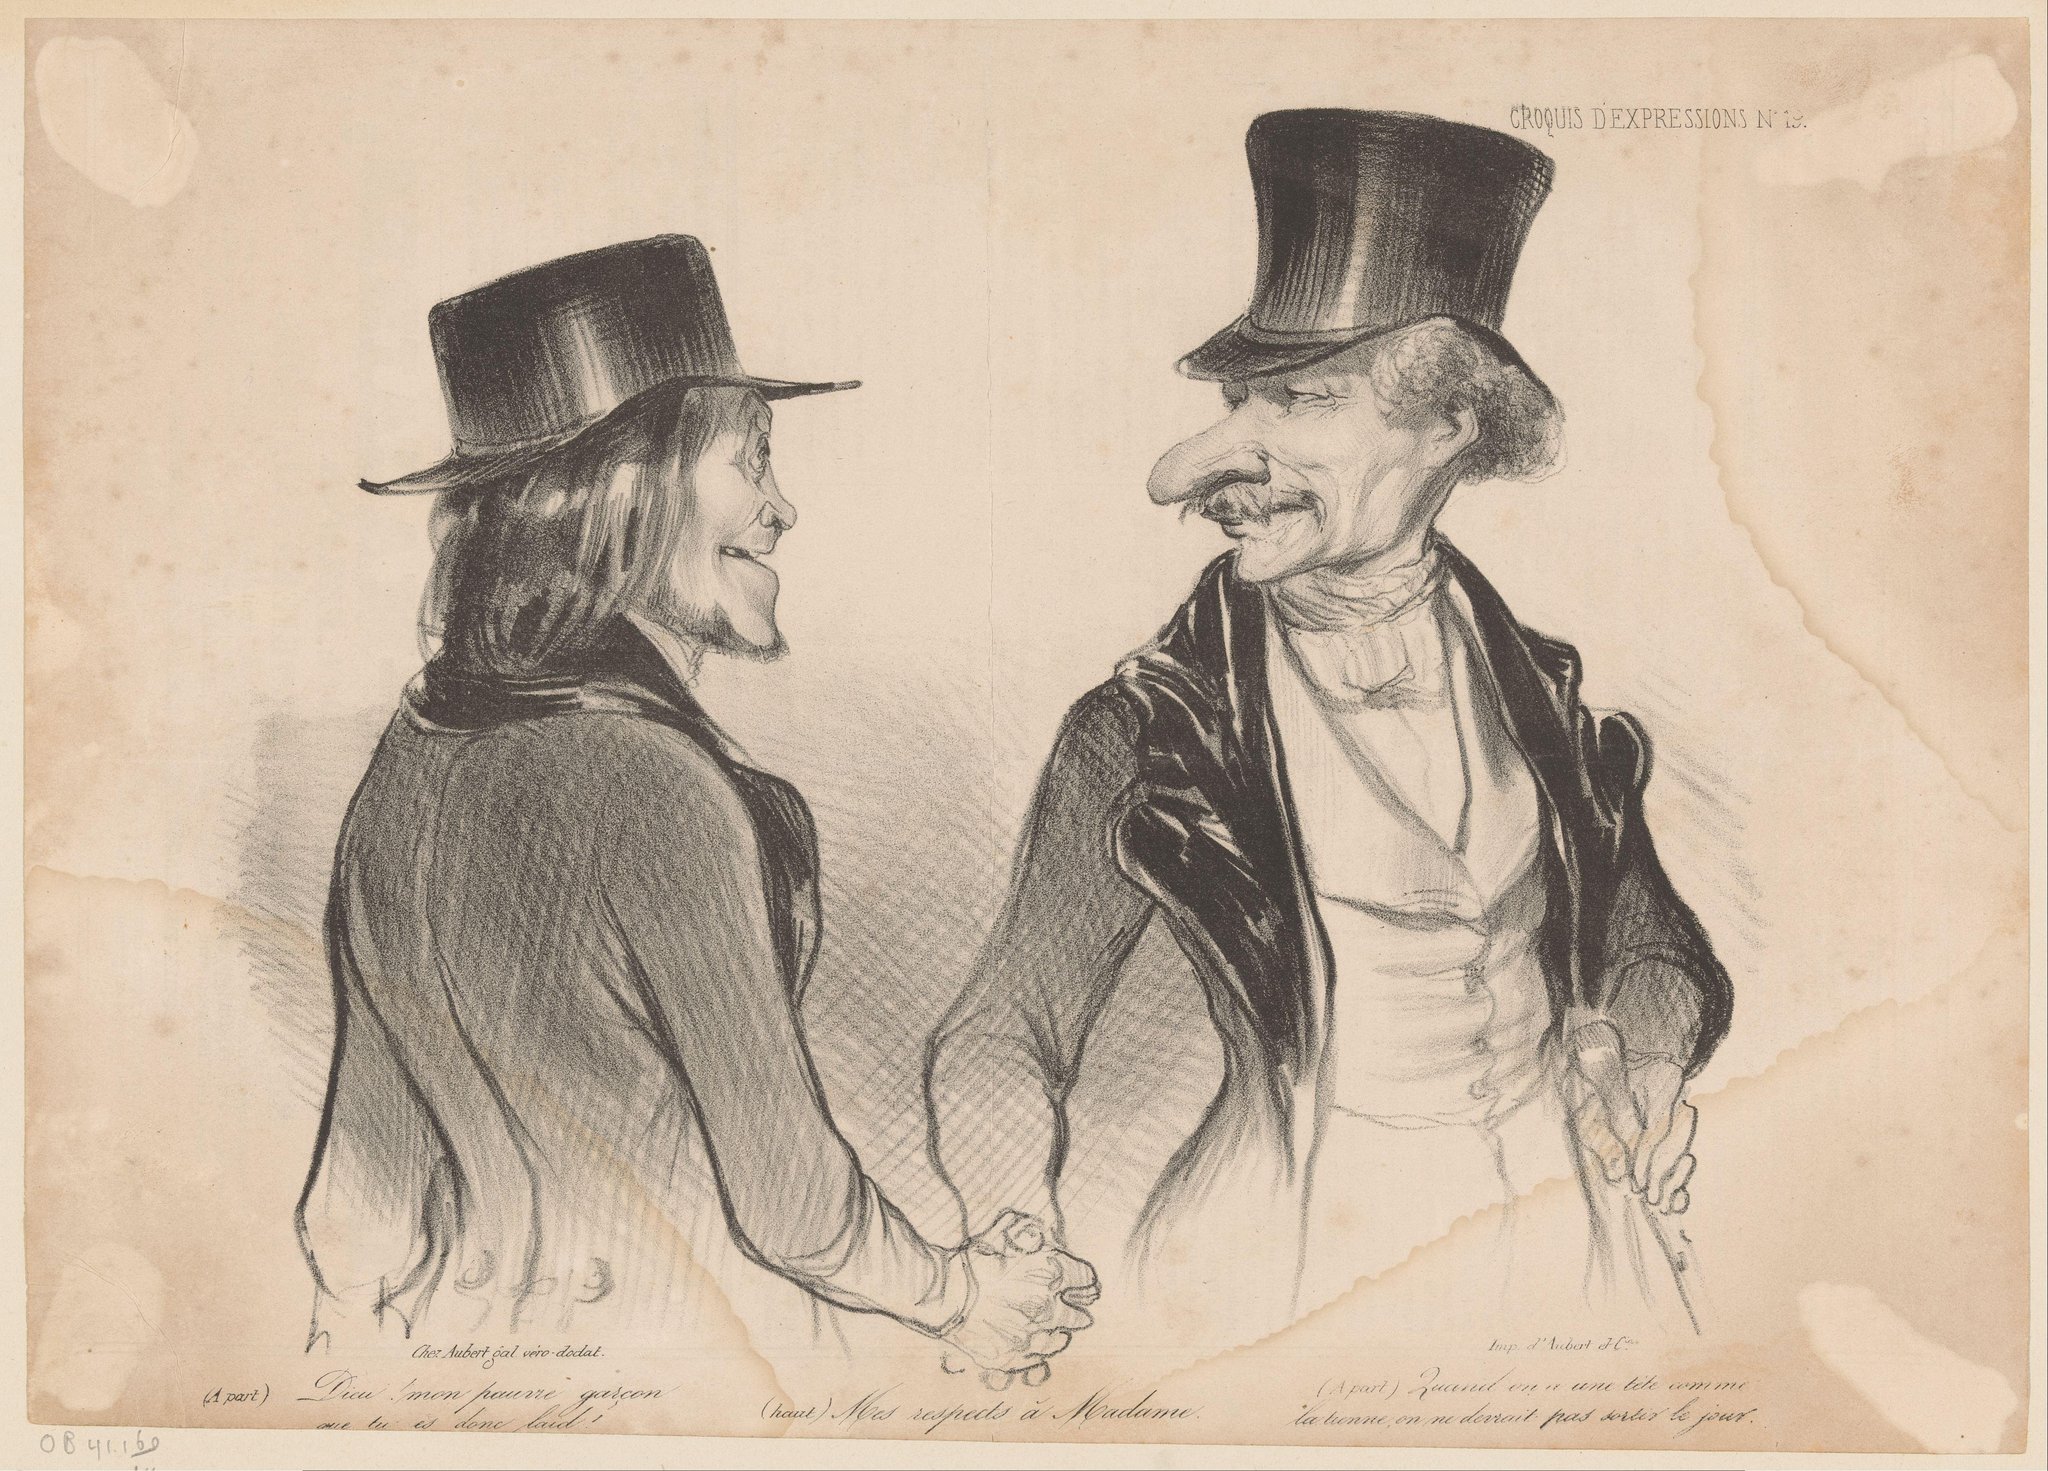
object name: cartoon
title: Gezichtsuitdrukkingen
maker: honoré daumier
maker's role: draughtsman, painter, print maker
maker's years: 1808-1879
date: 1838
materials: paper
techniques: letterpress printing, lithograph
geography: paris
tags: shaking hands, 'dextrarum junctio', caricatures (human types)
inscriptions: collector's mark: Lugt 2228a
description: Prent mogelijk uit: Le Charivari, juli 1838.